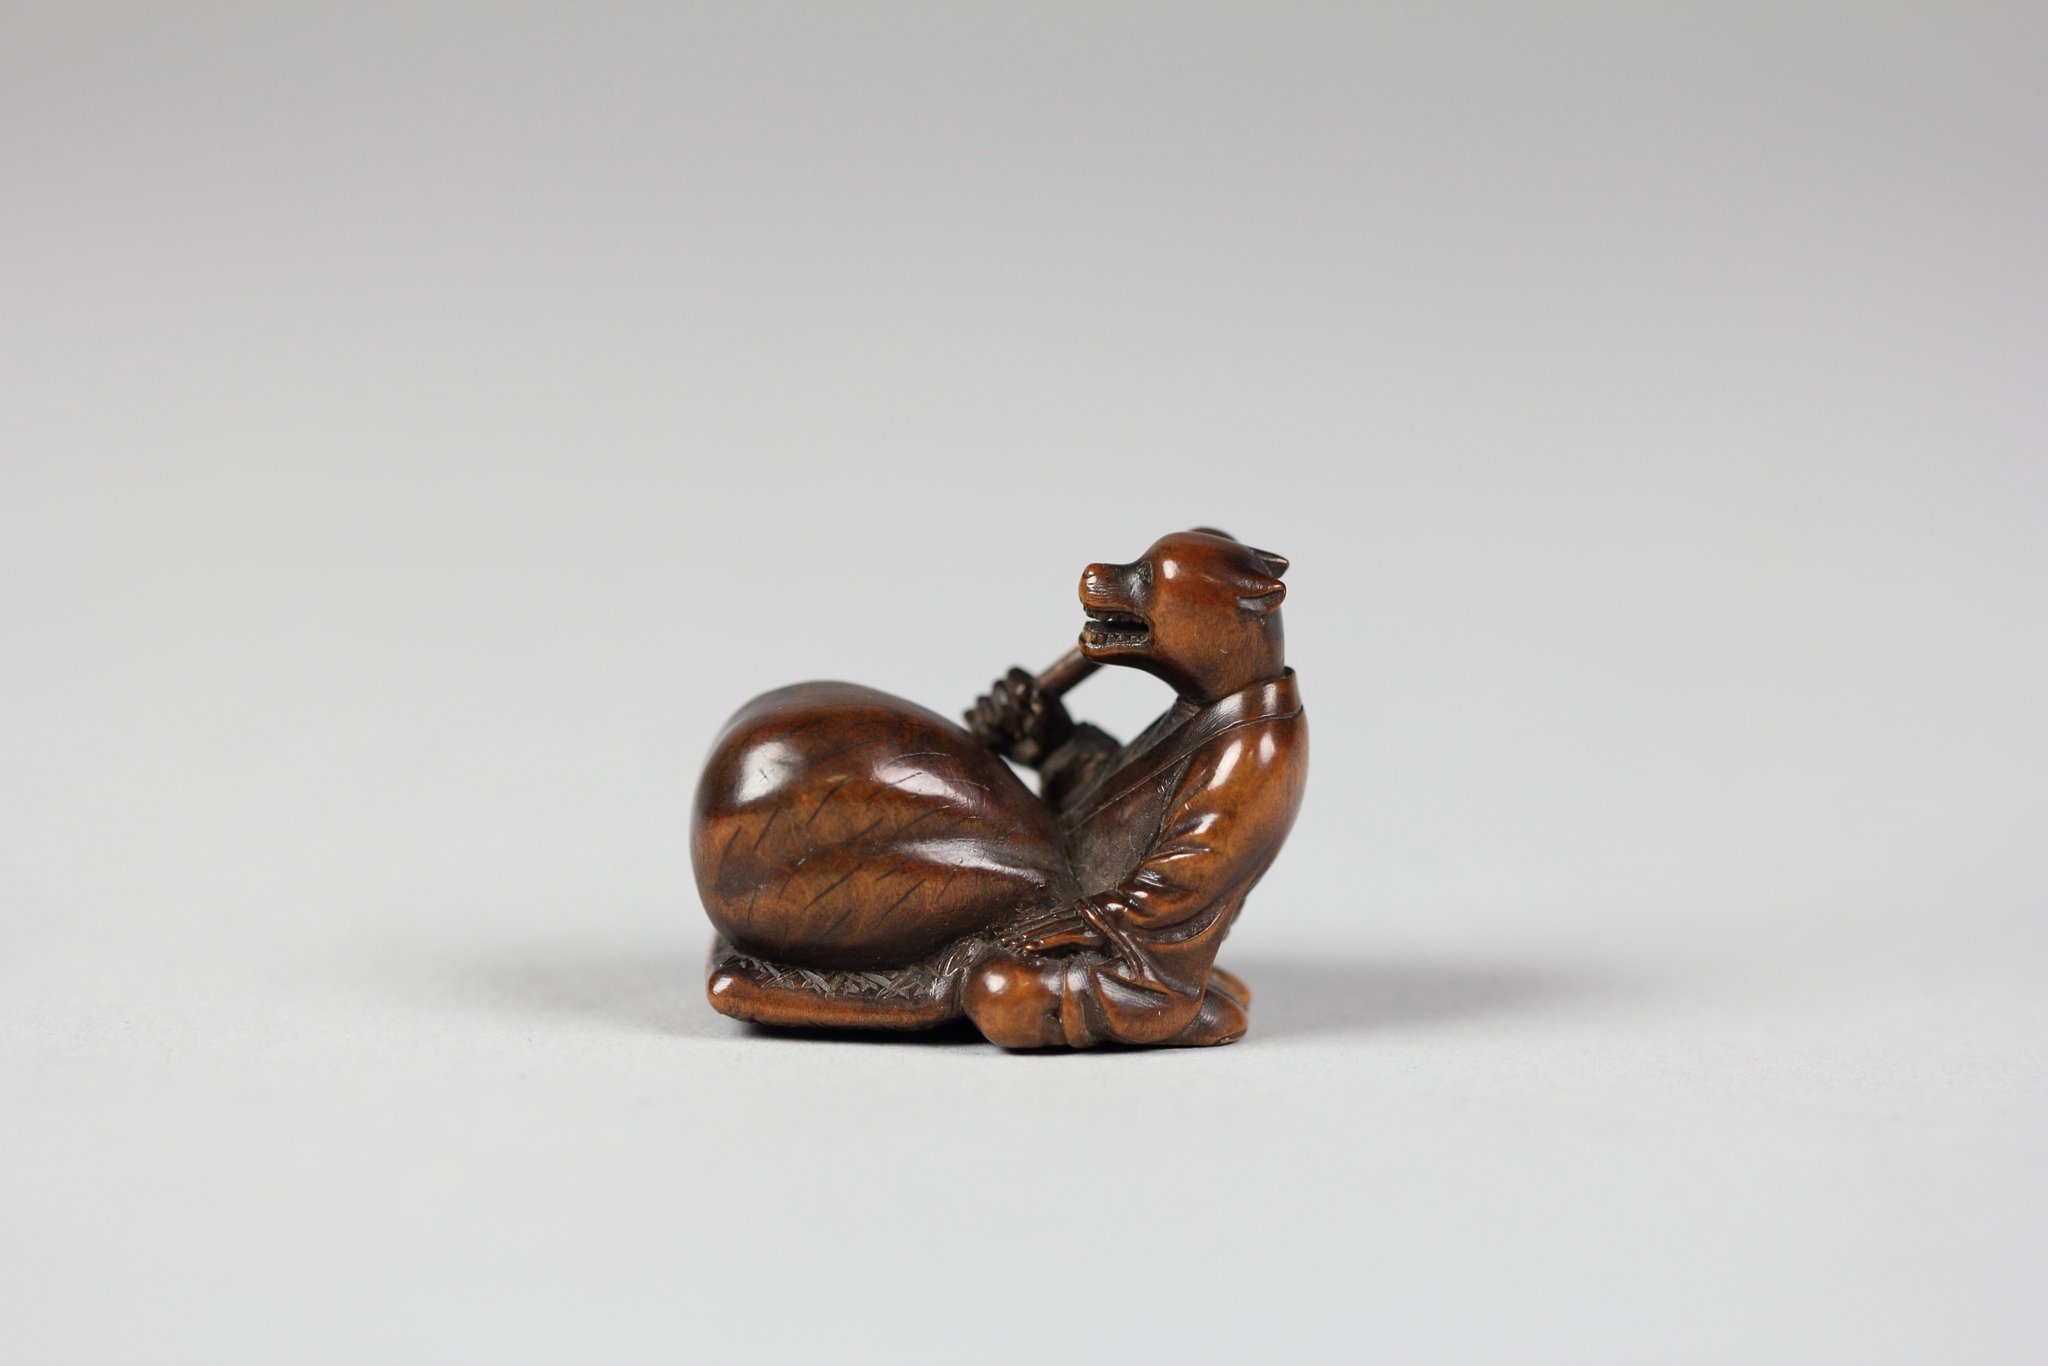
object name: netsuke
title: Netsuke: Tanuki no Hara Tsutsumi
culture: japanese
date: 1701-1800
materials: wood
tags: mythical creatures